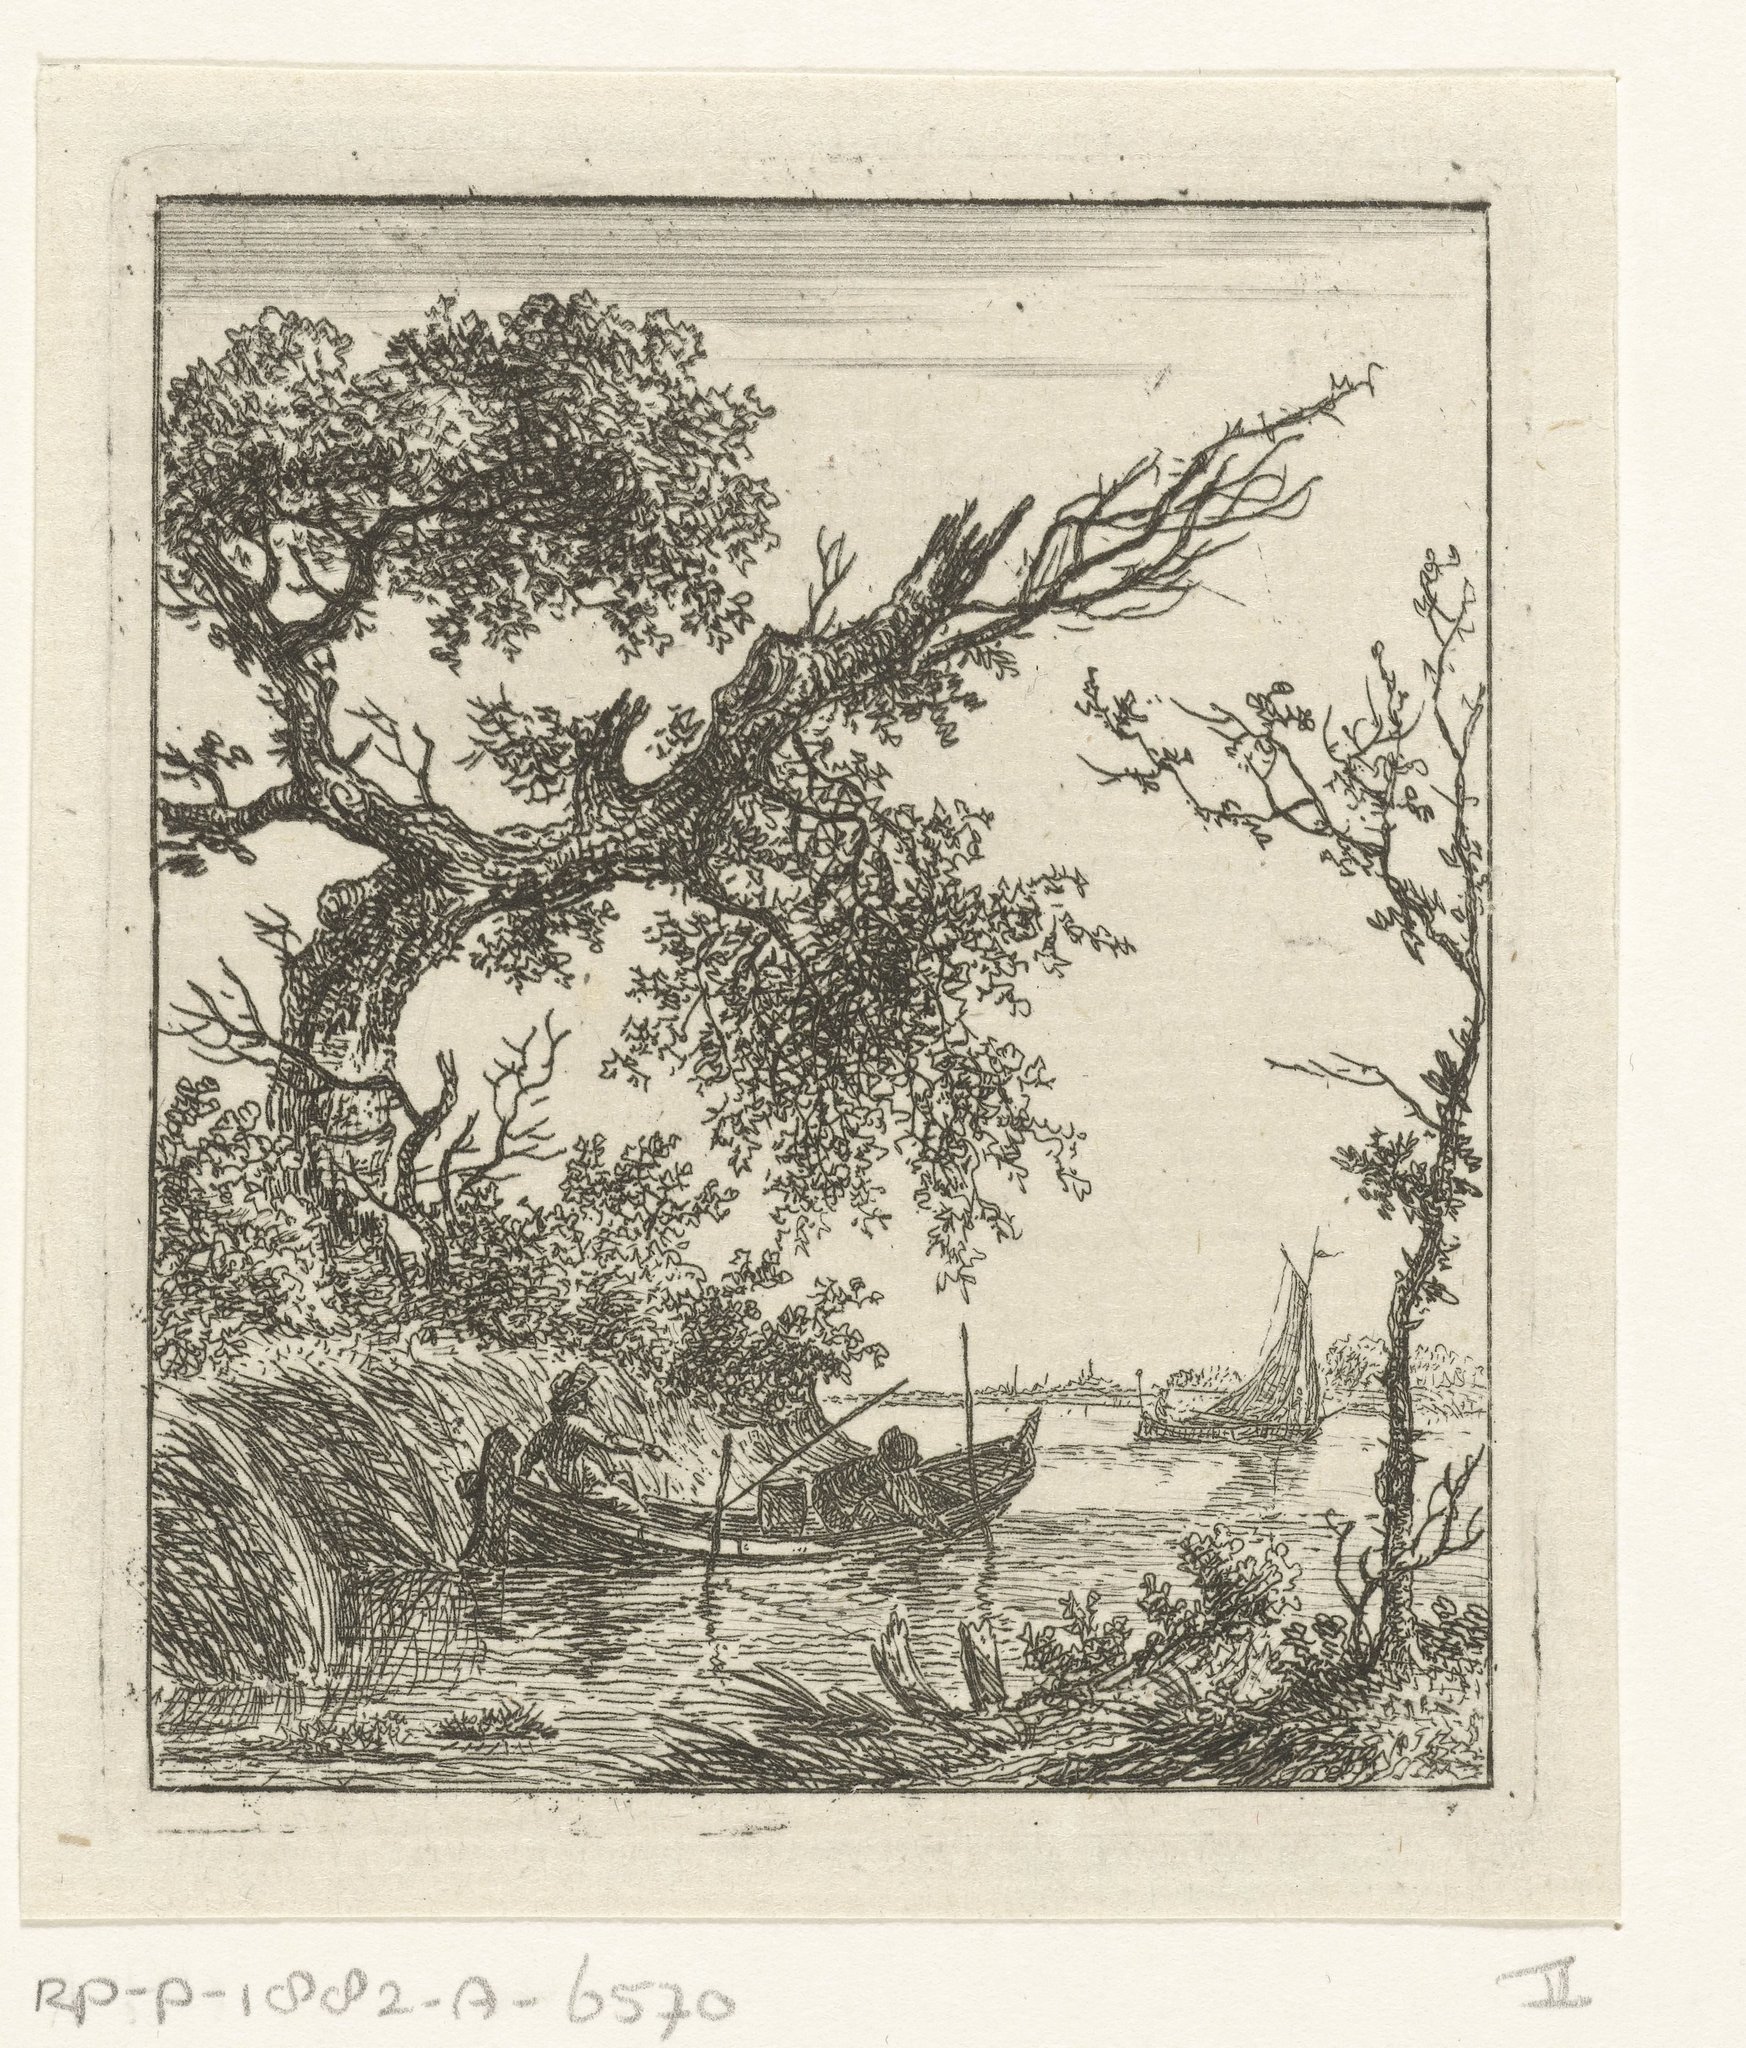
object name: print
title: Roeiboot met twee mannen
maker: hermanus fock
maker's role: conservator, draughtsman, painter, print maker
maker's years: 1766-1822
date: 1781-1822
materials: paper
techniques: etching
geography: amsterdam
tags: rowing-boat, canoe, etc.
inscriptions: collector's mark: Lugt 2228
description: Een gezicht op een grote overhangende boom en een roeiboot waar twee mannen in zitten. Op de achtergrond een zeilschip.